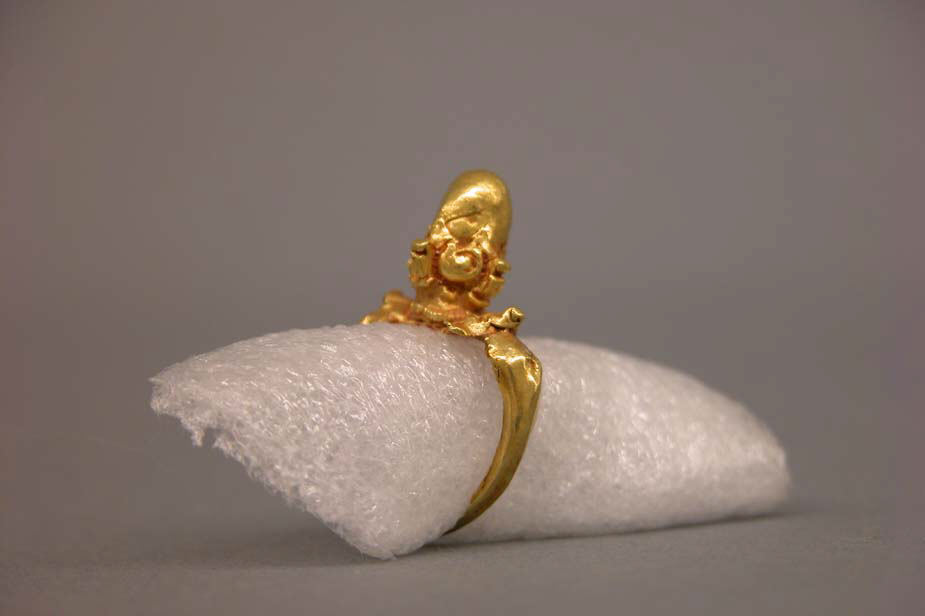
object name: ring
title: Ring with Linga Mounted on Bezel with Foliate Designs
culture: indonesian, javanese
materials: gold